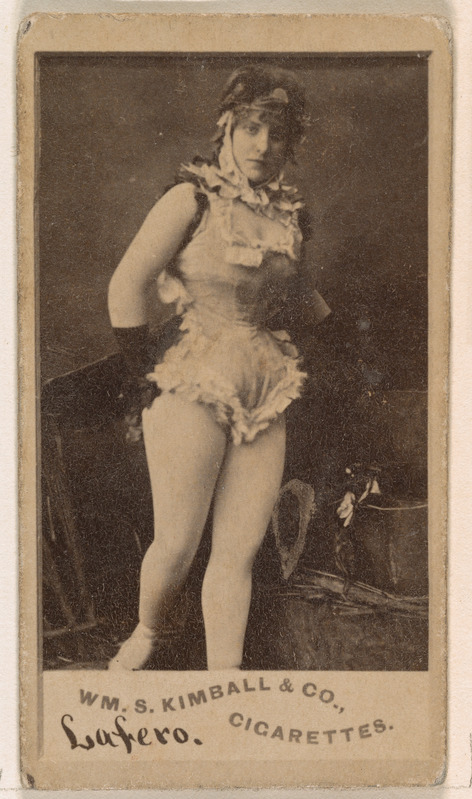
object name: photograph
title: Miss Lafero, from the Actresses series (N203) issued by Wm. S. Kimball & Co.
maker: william s. kimball & company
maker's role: publisher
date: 1889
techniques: color lithograph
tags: portraits,women,actresses